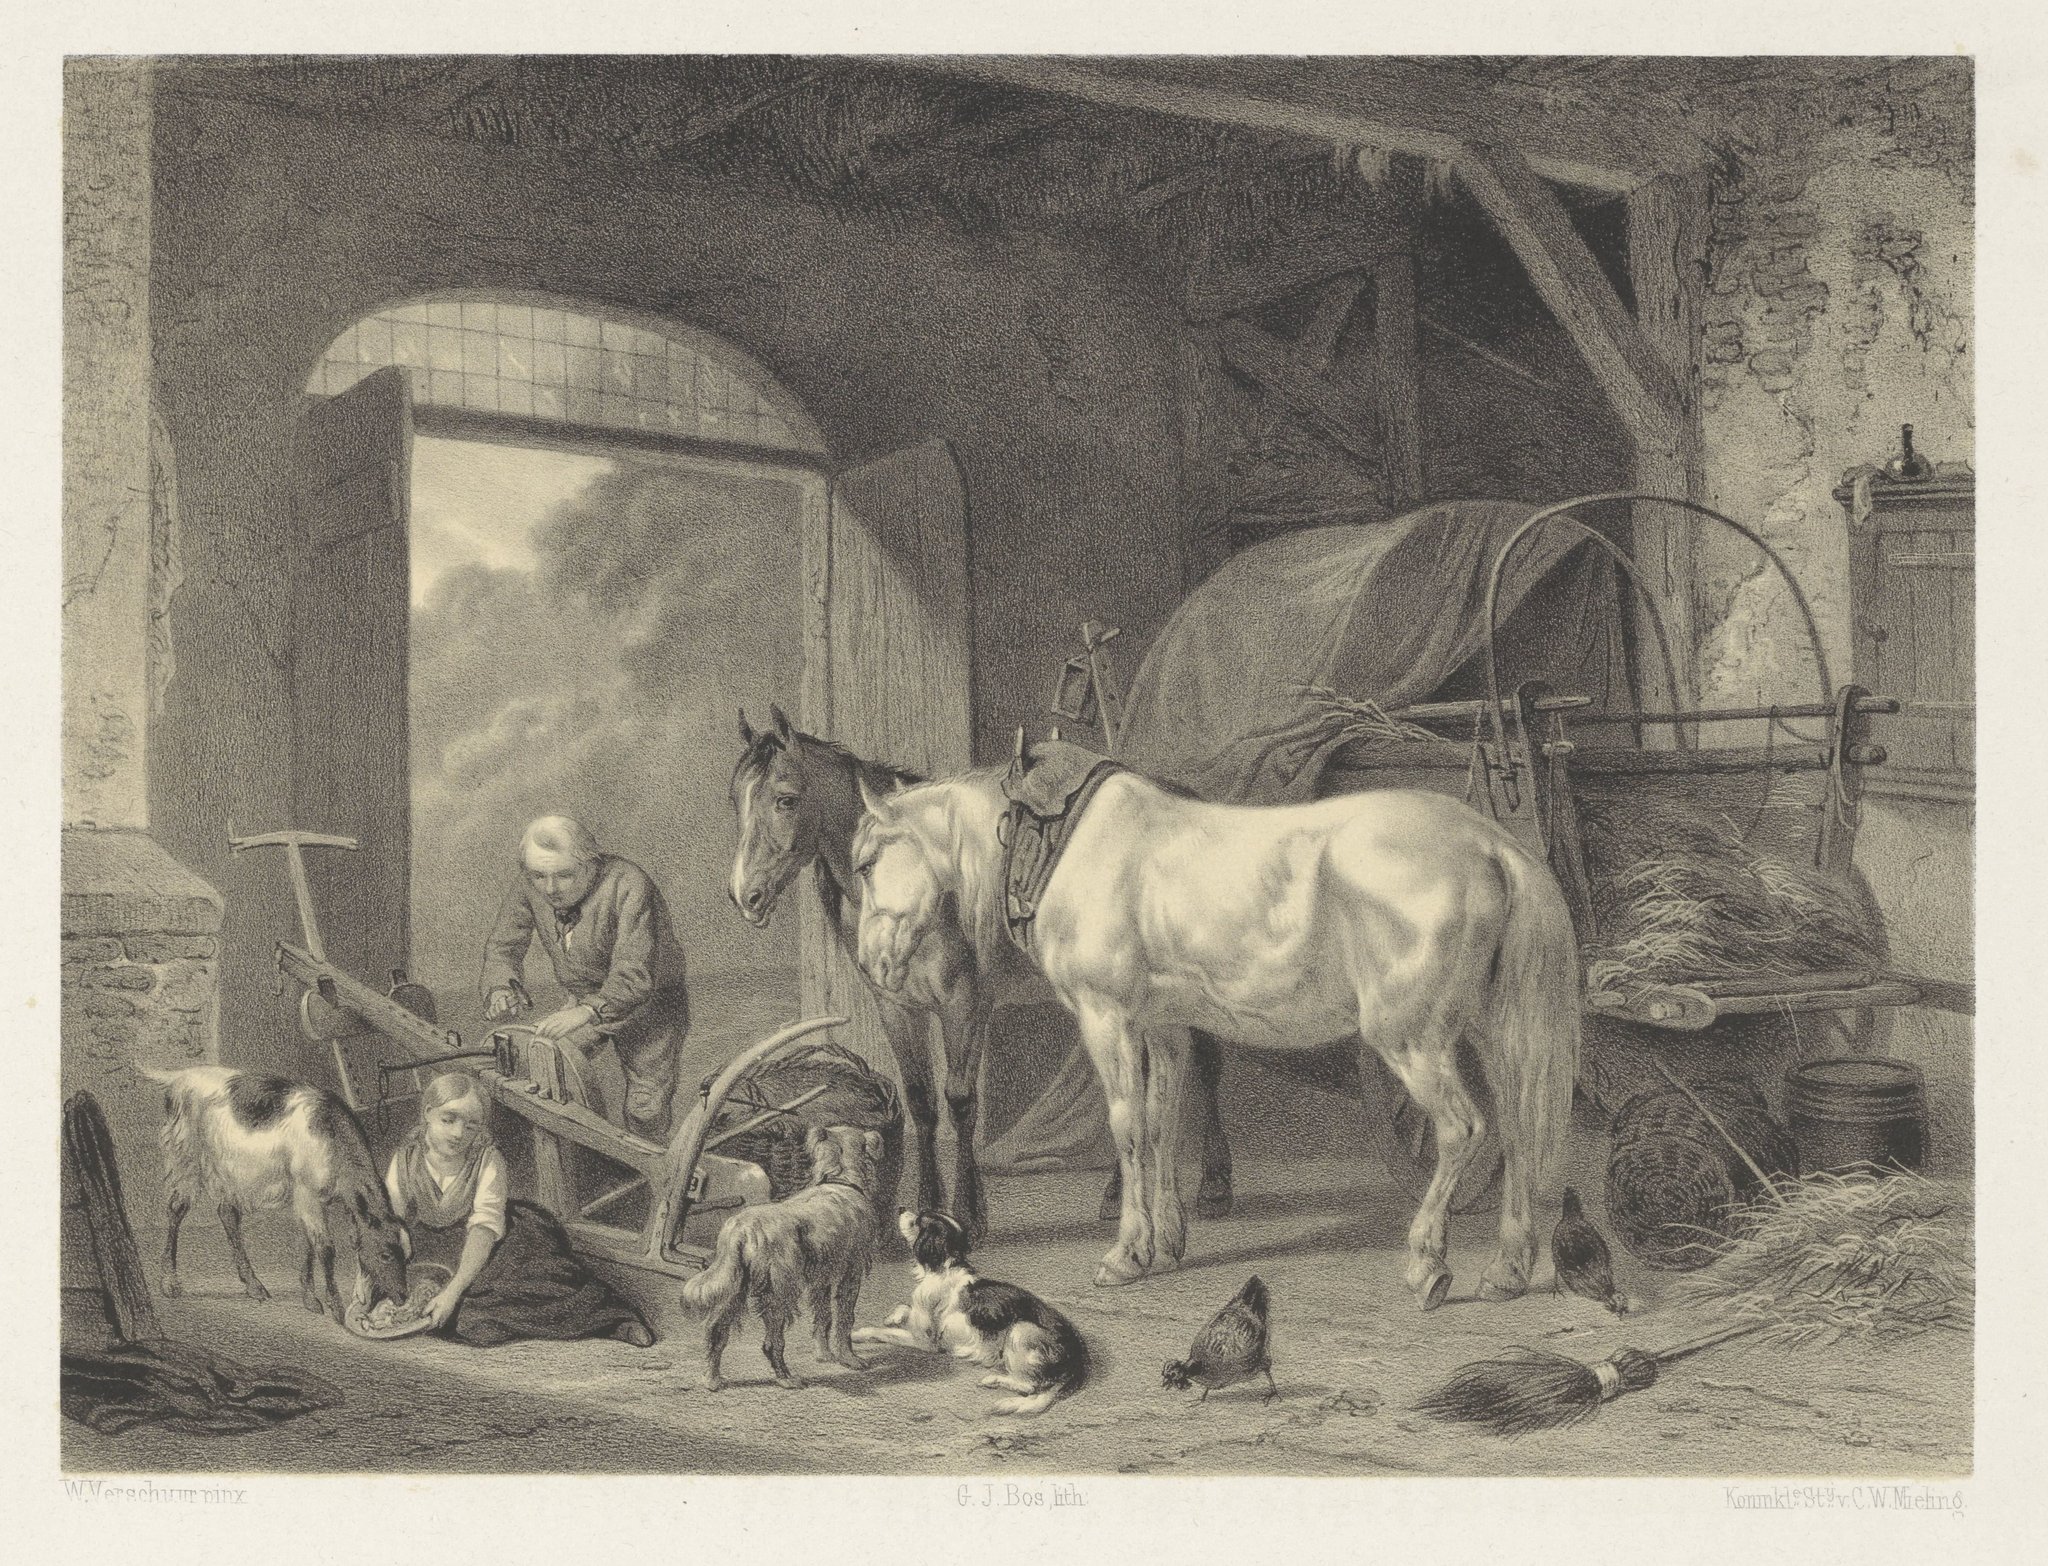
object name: print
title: Stal met twee figuren en dieren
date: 1858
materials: paper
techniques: tone lithography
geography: netherlands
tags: barn, handicrafts ~ maintenance and repair, horse, goat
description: Een man werkt aan een machine. Daarnaast zit een meisje op de grond, zij voert een geit. In het midden van de stal staan twee paarden, deels opgetuigd. Achter hen een kar met stro.